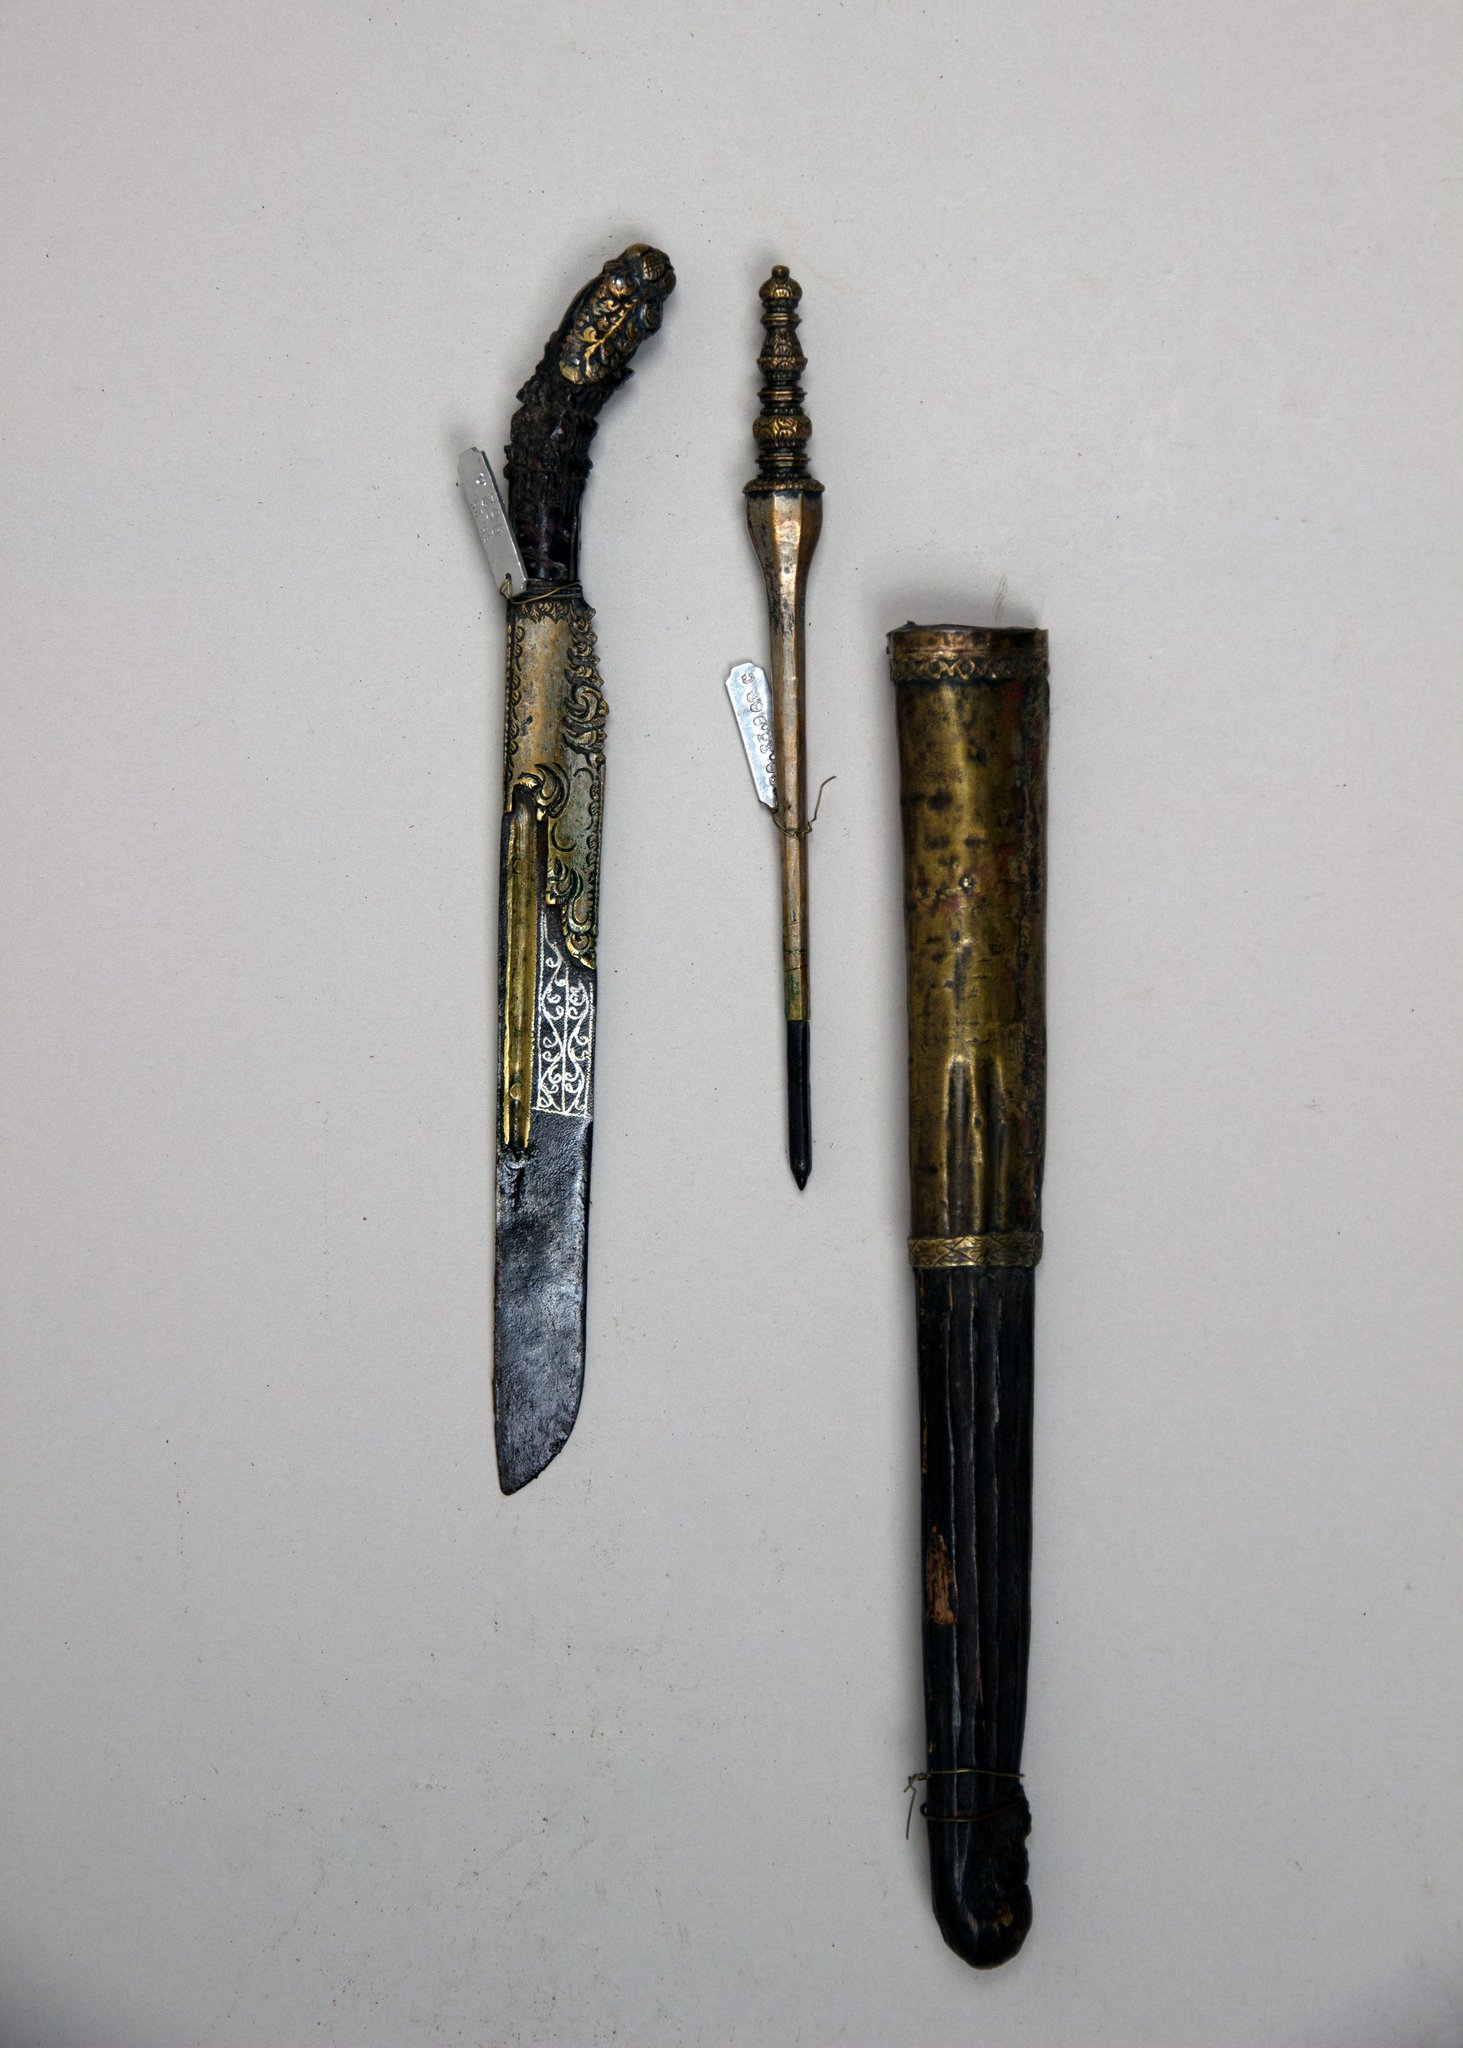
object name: knife piha kaetta with sheath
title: Knife (Piha Kaetta) with Stylus and Sheath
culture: sri lankan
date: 1701-1900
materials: brass, copper, silver, steel, wood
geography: sri lanka